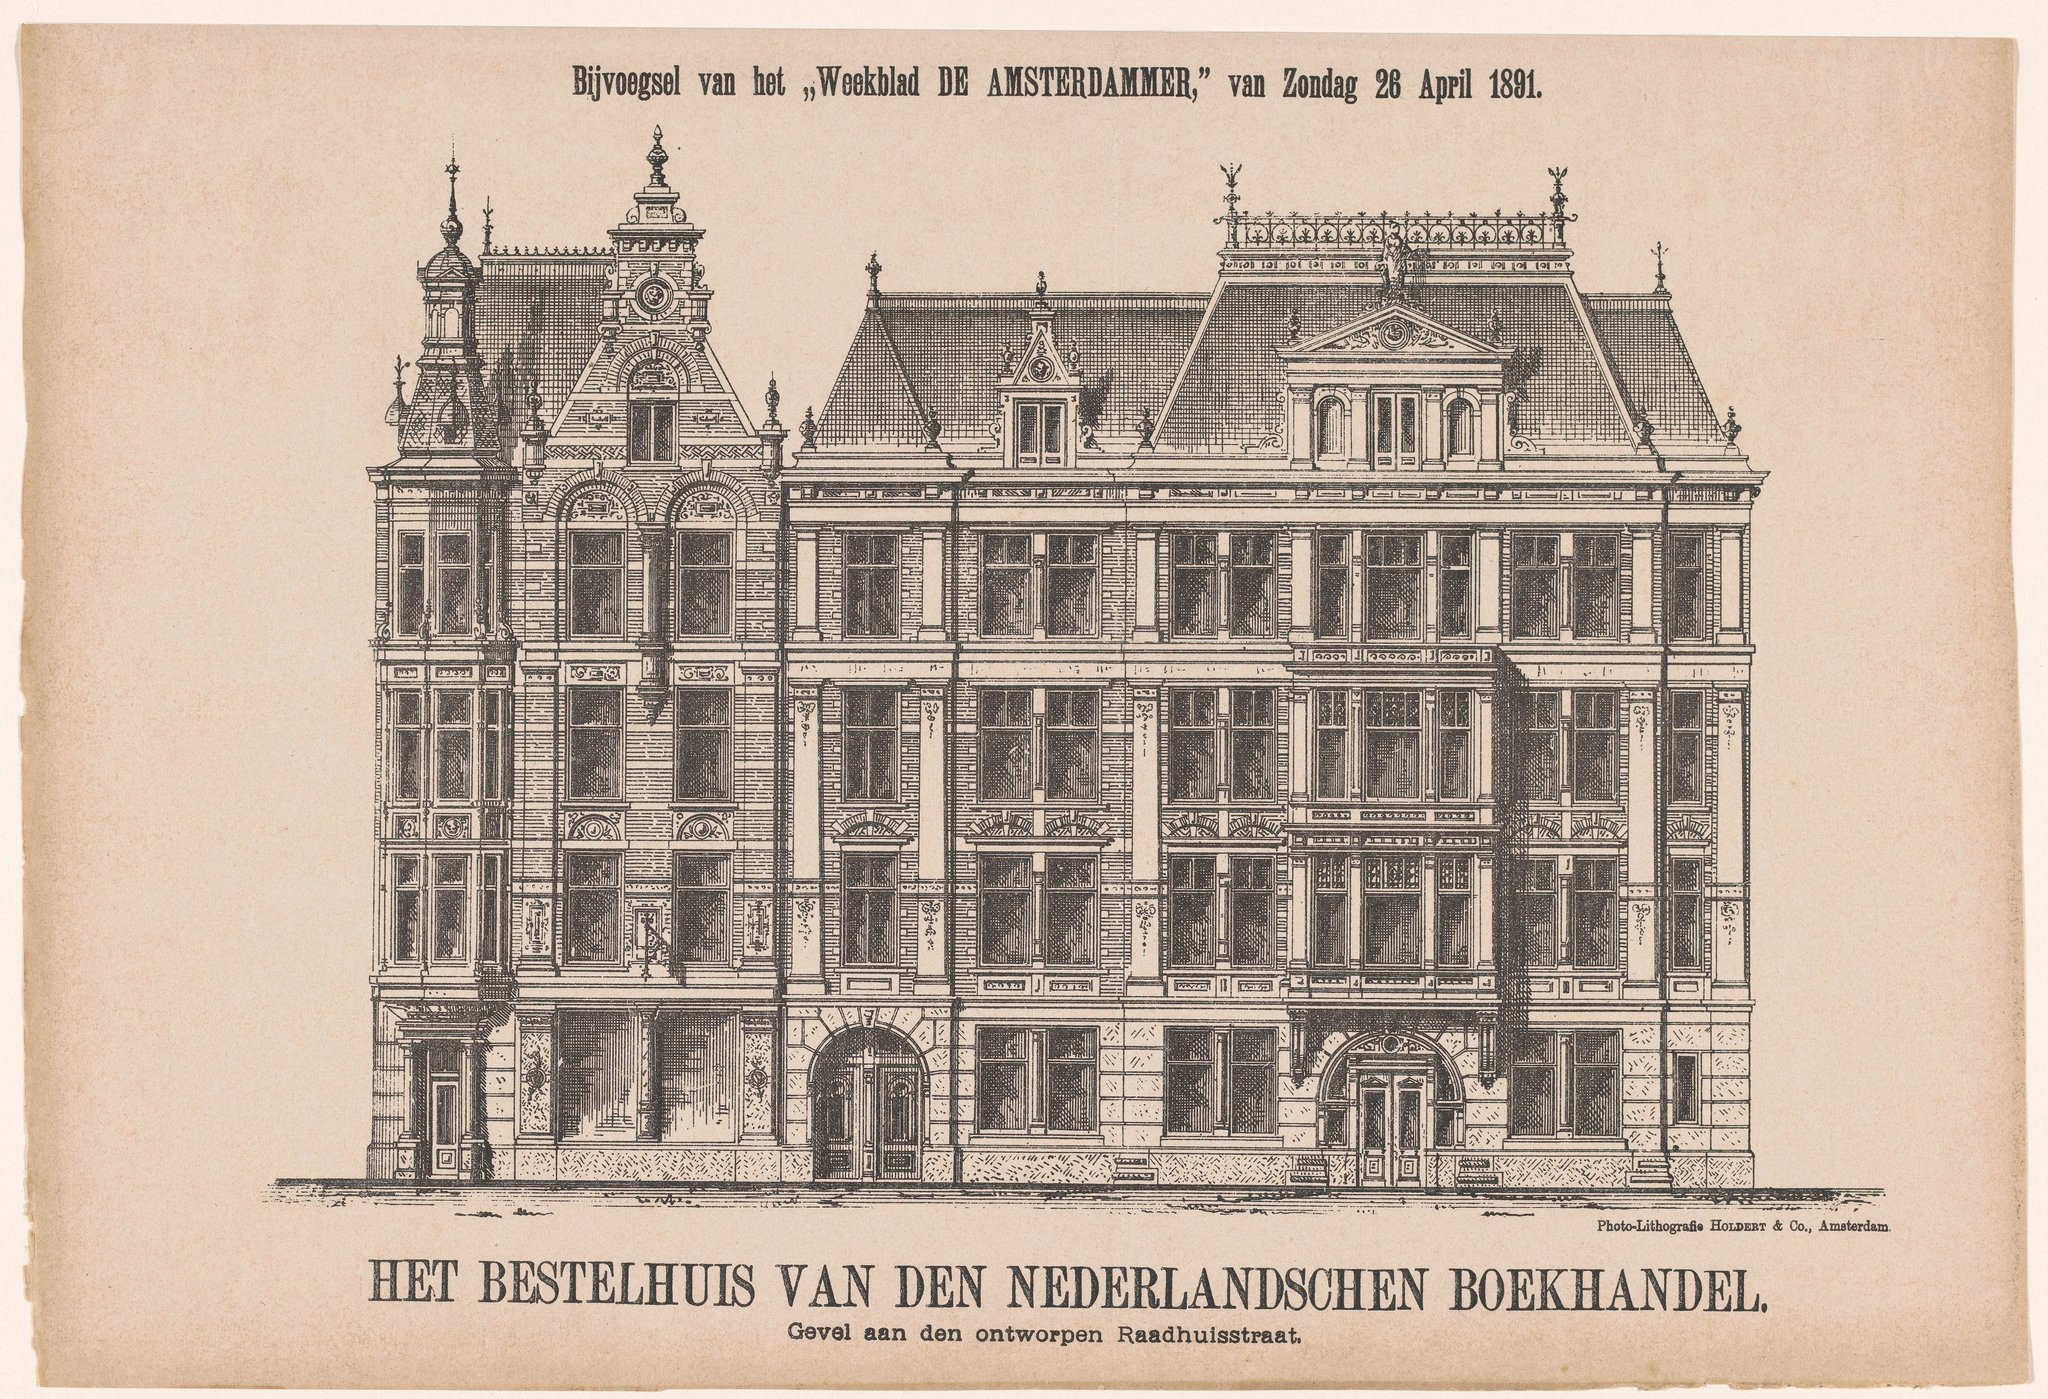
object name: print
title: Gevel van het Bestelhuis van den Nederlandschen Boekhandel te Amsterdam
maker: Anonymous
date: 1891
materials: paper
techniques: photolithography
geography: amsterdam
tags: façade (of house or building)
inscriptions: collector's mark: Lugt 4779, collector's mark: Lugt 2228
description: Gevel van het Bestelhuis van den Nederlandschen Boekhandel aan de Raadhuisstraat te Amsterdam.